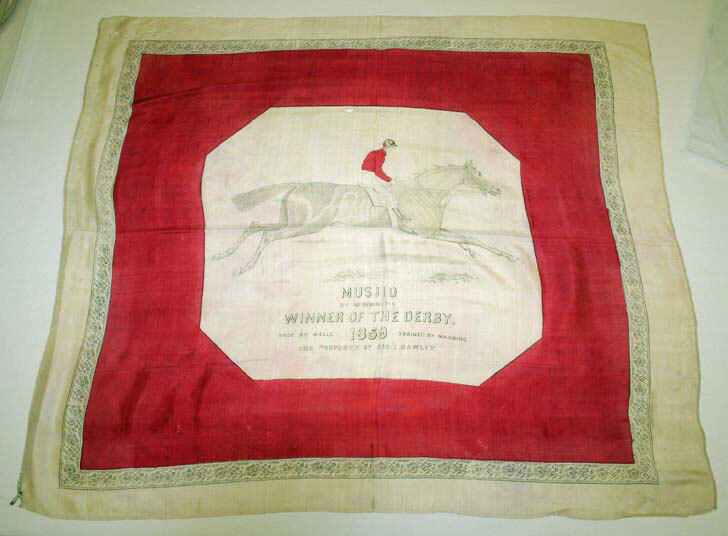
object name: handkerchief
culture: british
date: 1859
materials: silk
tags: horses,jockeys